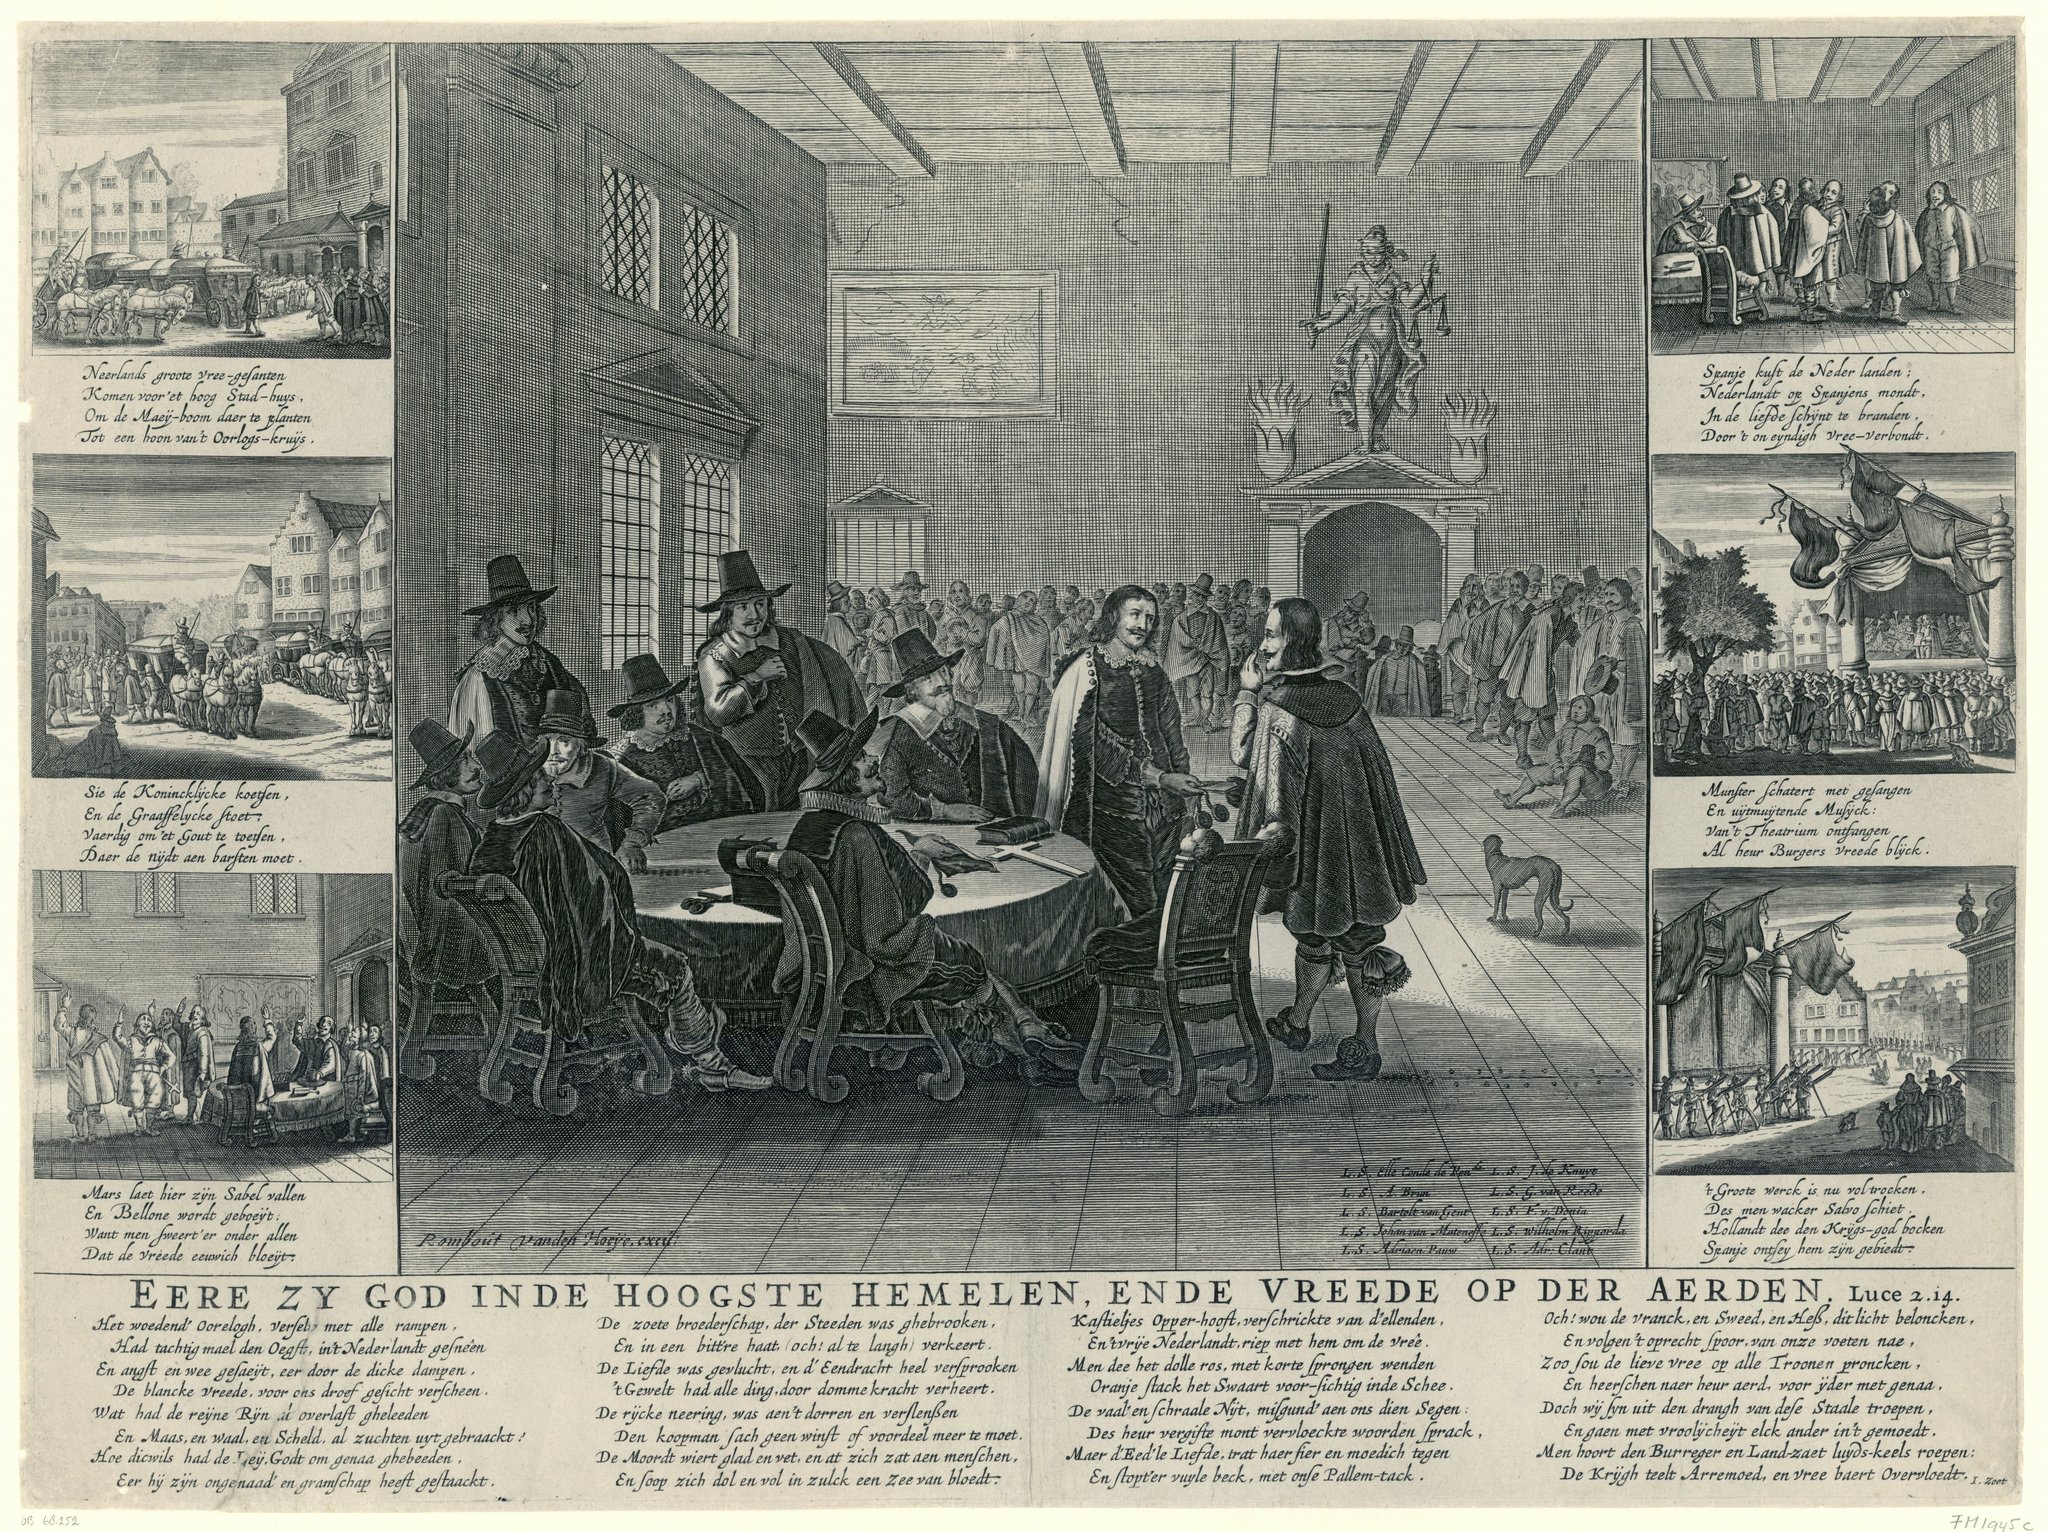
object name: print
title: Eere zy God in de hoogste hemelen, ende vreede op der aerden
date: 1648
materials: paper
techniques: engraving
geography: northern netherlands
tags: gaspar de bracamonte y guzman (graaf van peñaranda), amsterdam, the hague, politician, adriaen pauw (1585-1653), utrecht, signing of peace treaty, concluding the peace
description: Blad met verschillende voorstellingen van de gebeurtenissen rond het sluiten van de Vrede van Munster. Centraal de uitwisseling van de ratificatie in de Friedenssaal van het stadhuis van Munster tussen de Staatse en Spaanse gedelegeerden Antoine Brun en de graaf van Peñaranda. Links de Staatse afgevaardigden zittend rond een tafel. Rechts onderaan de namen van de onderhandelaars. Om de centrale voorstelling staan zes kleinere scènes van eerdere en latere momenten: de aankomst van de afgevaardigden, de vredesonderhandelingen, de bekendmaking van de vrede en het salvoschieten te Munster. Elke voorstelling wordt begeleid door een vers van 4 regels. Onderaan 4 verzen van 8 regels in het Nederlands.